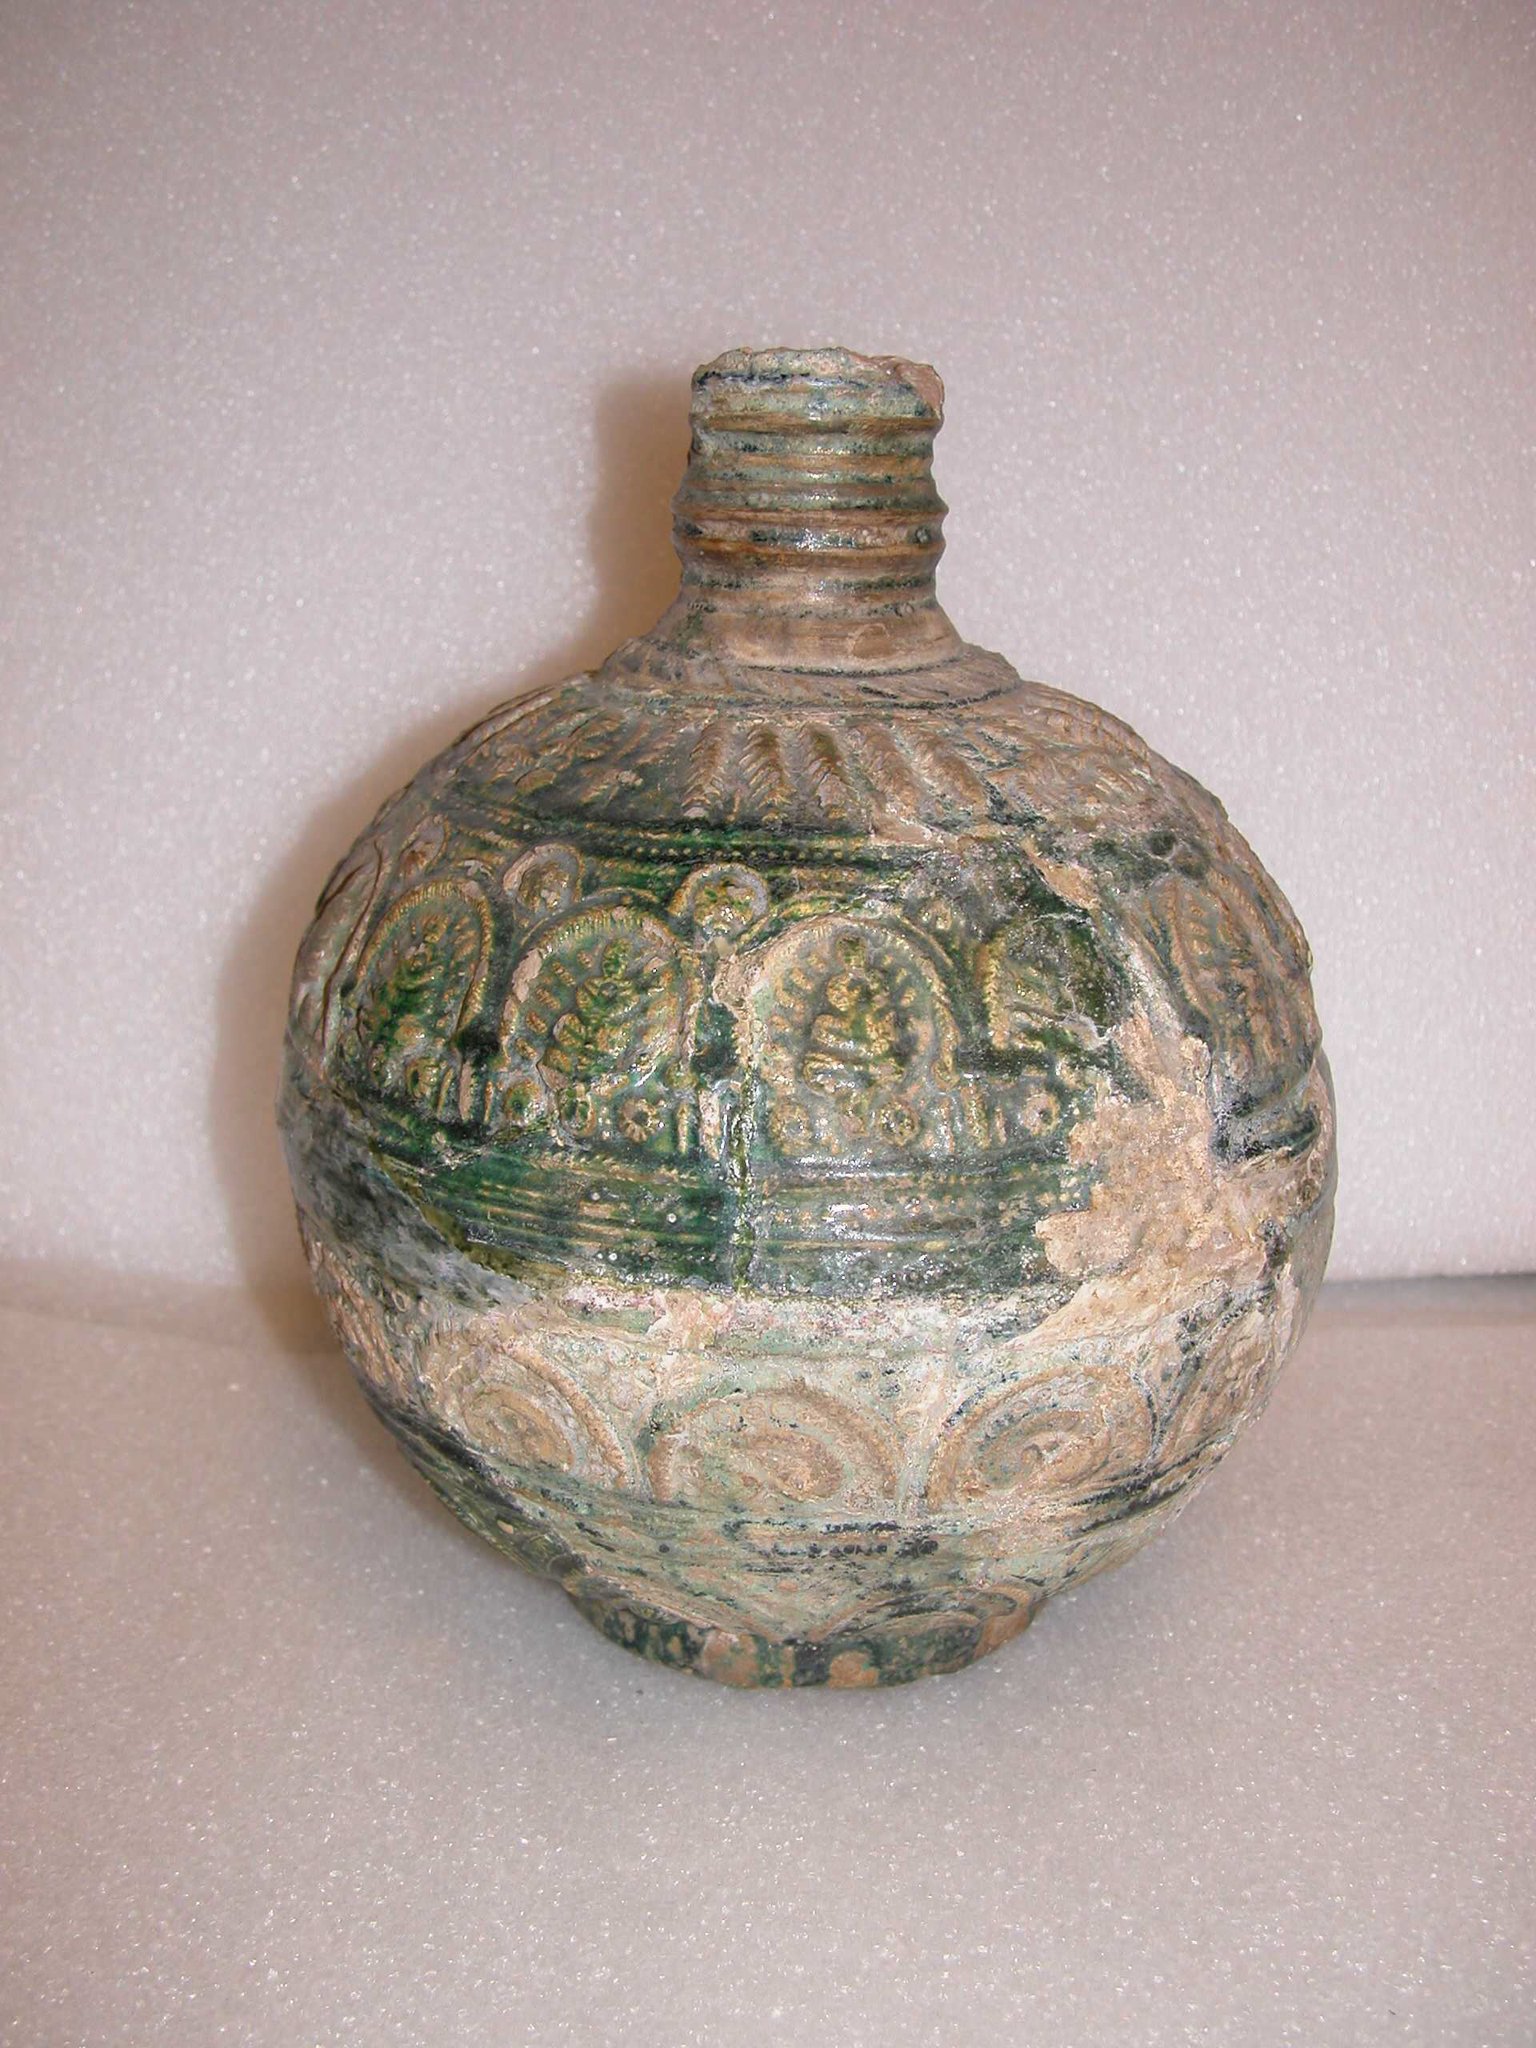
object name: jar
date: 701-800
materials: earthenware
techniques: glazing, molding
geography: iran